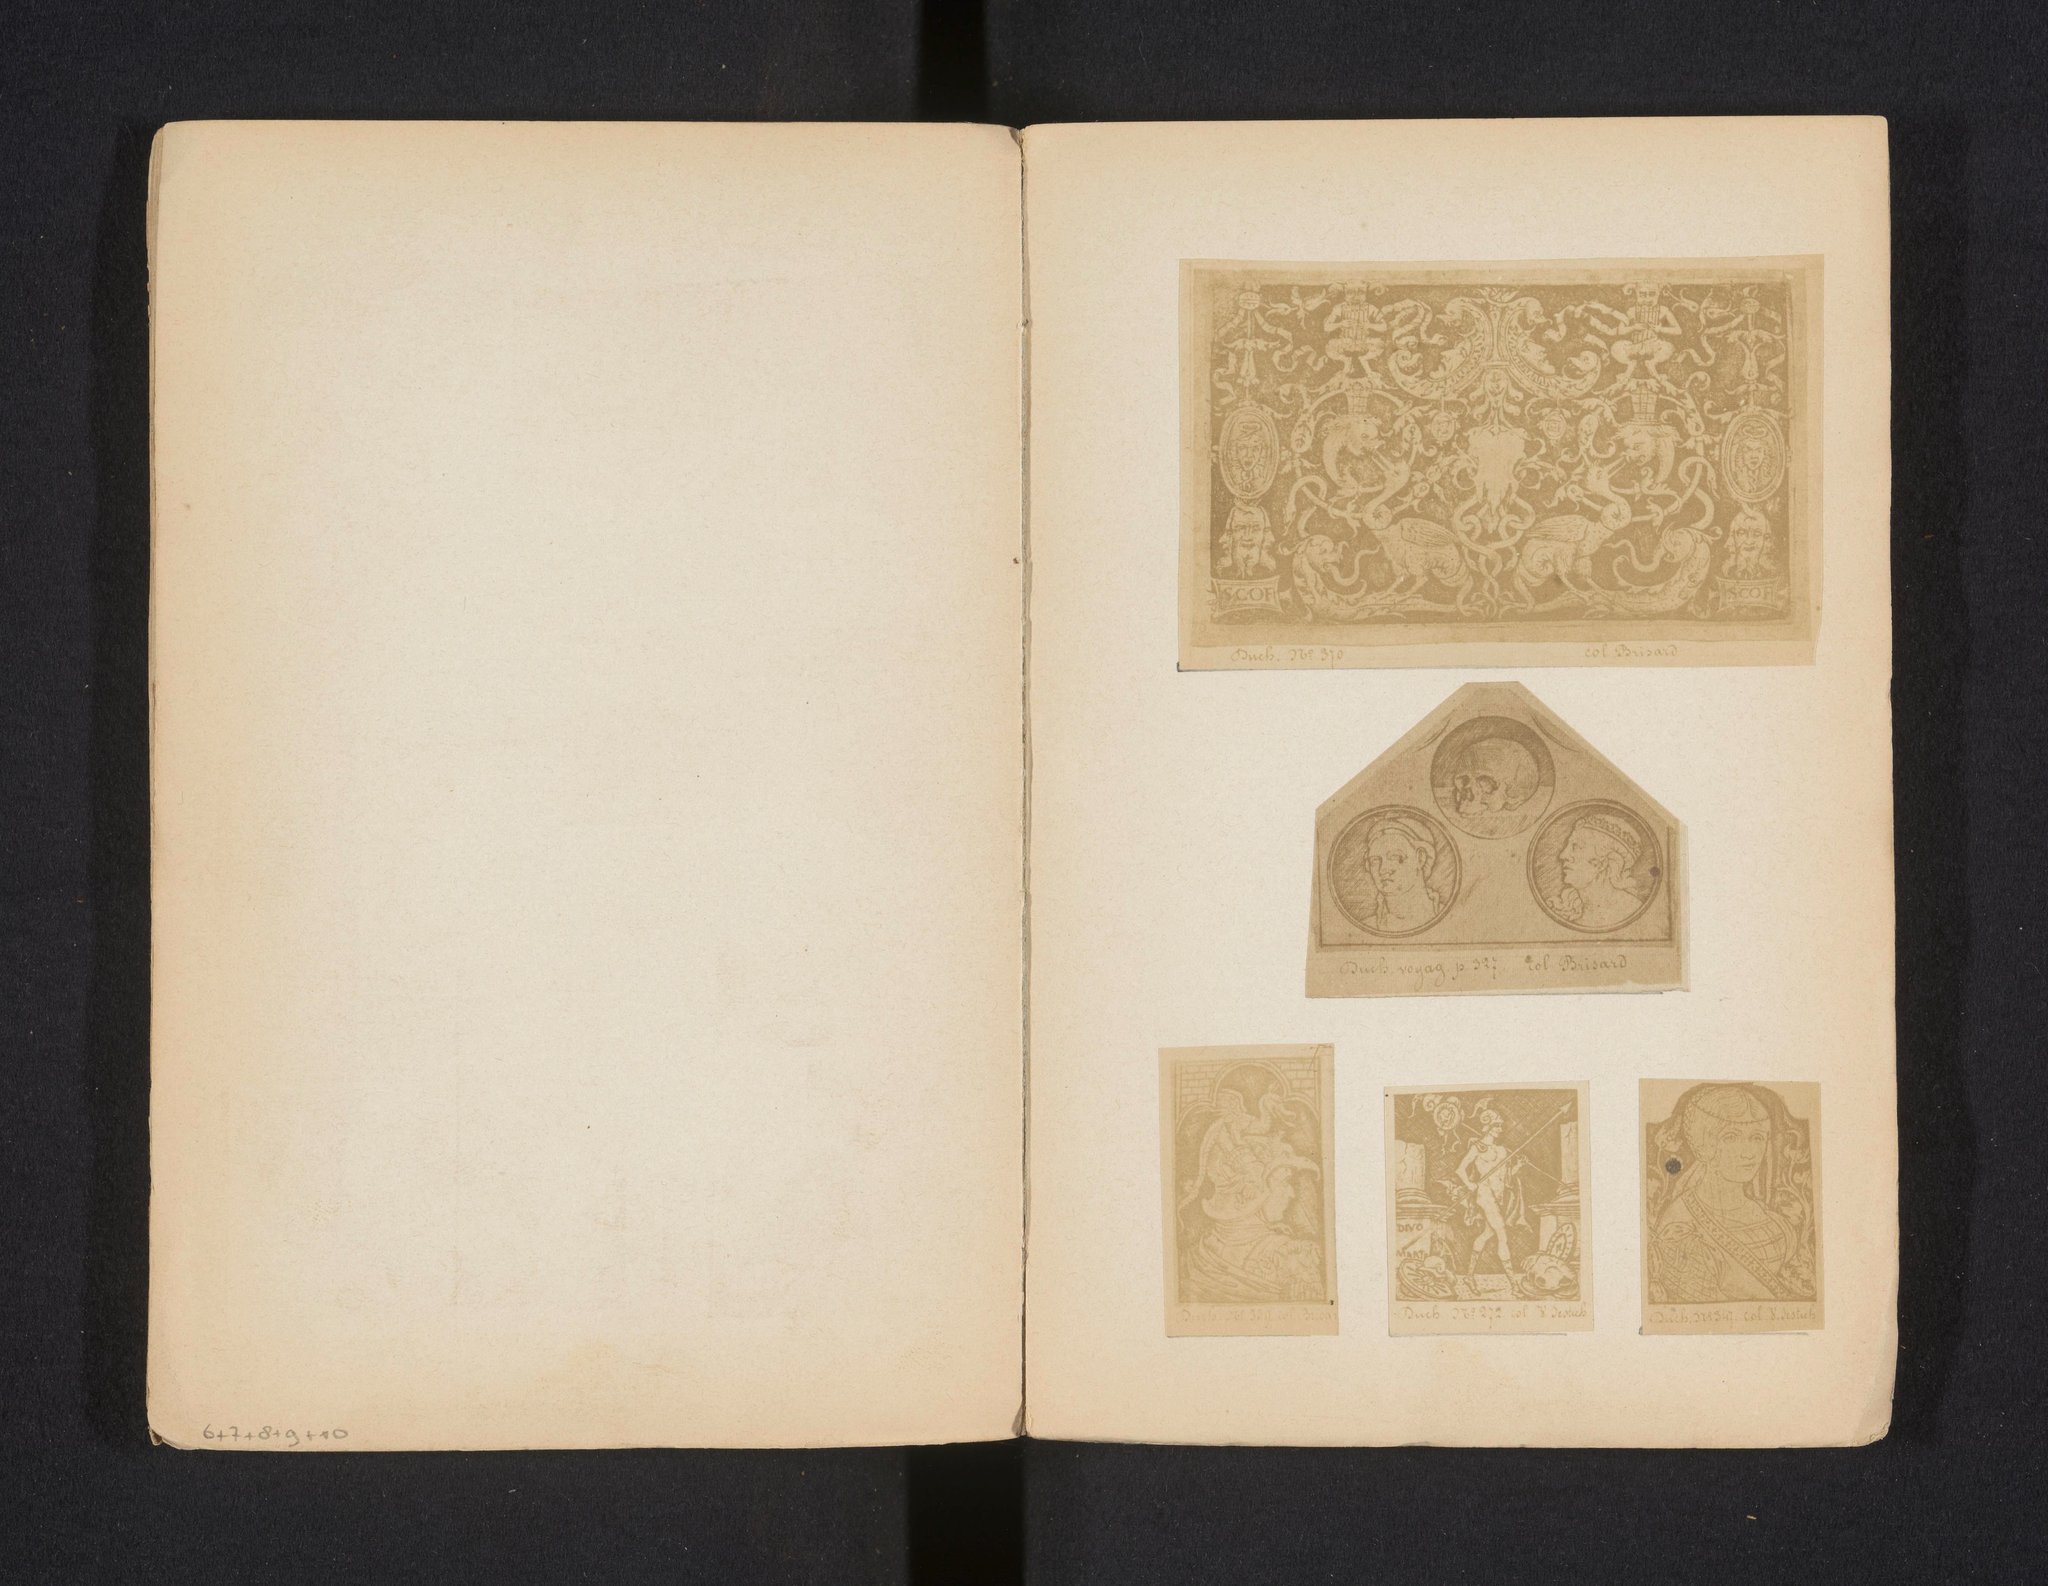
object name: photograph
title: Fotoreproductie van een prent van een man met een helm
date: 1853-1858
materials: photographic support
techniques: salted paper print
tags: helmet, adult man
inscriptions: inscription: ‘Duch. No 339. col. Brisard’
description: Foto op vijfde ongenummerde pagina na pagina 142.